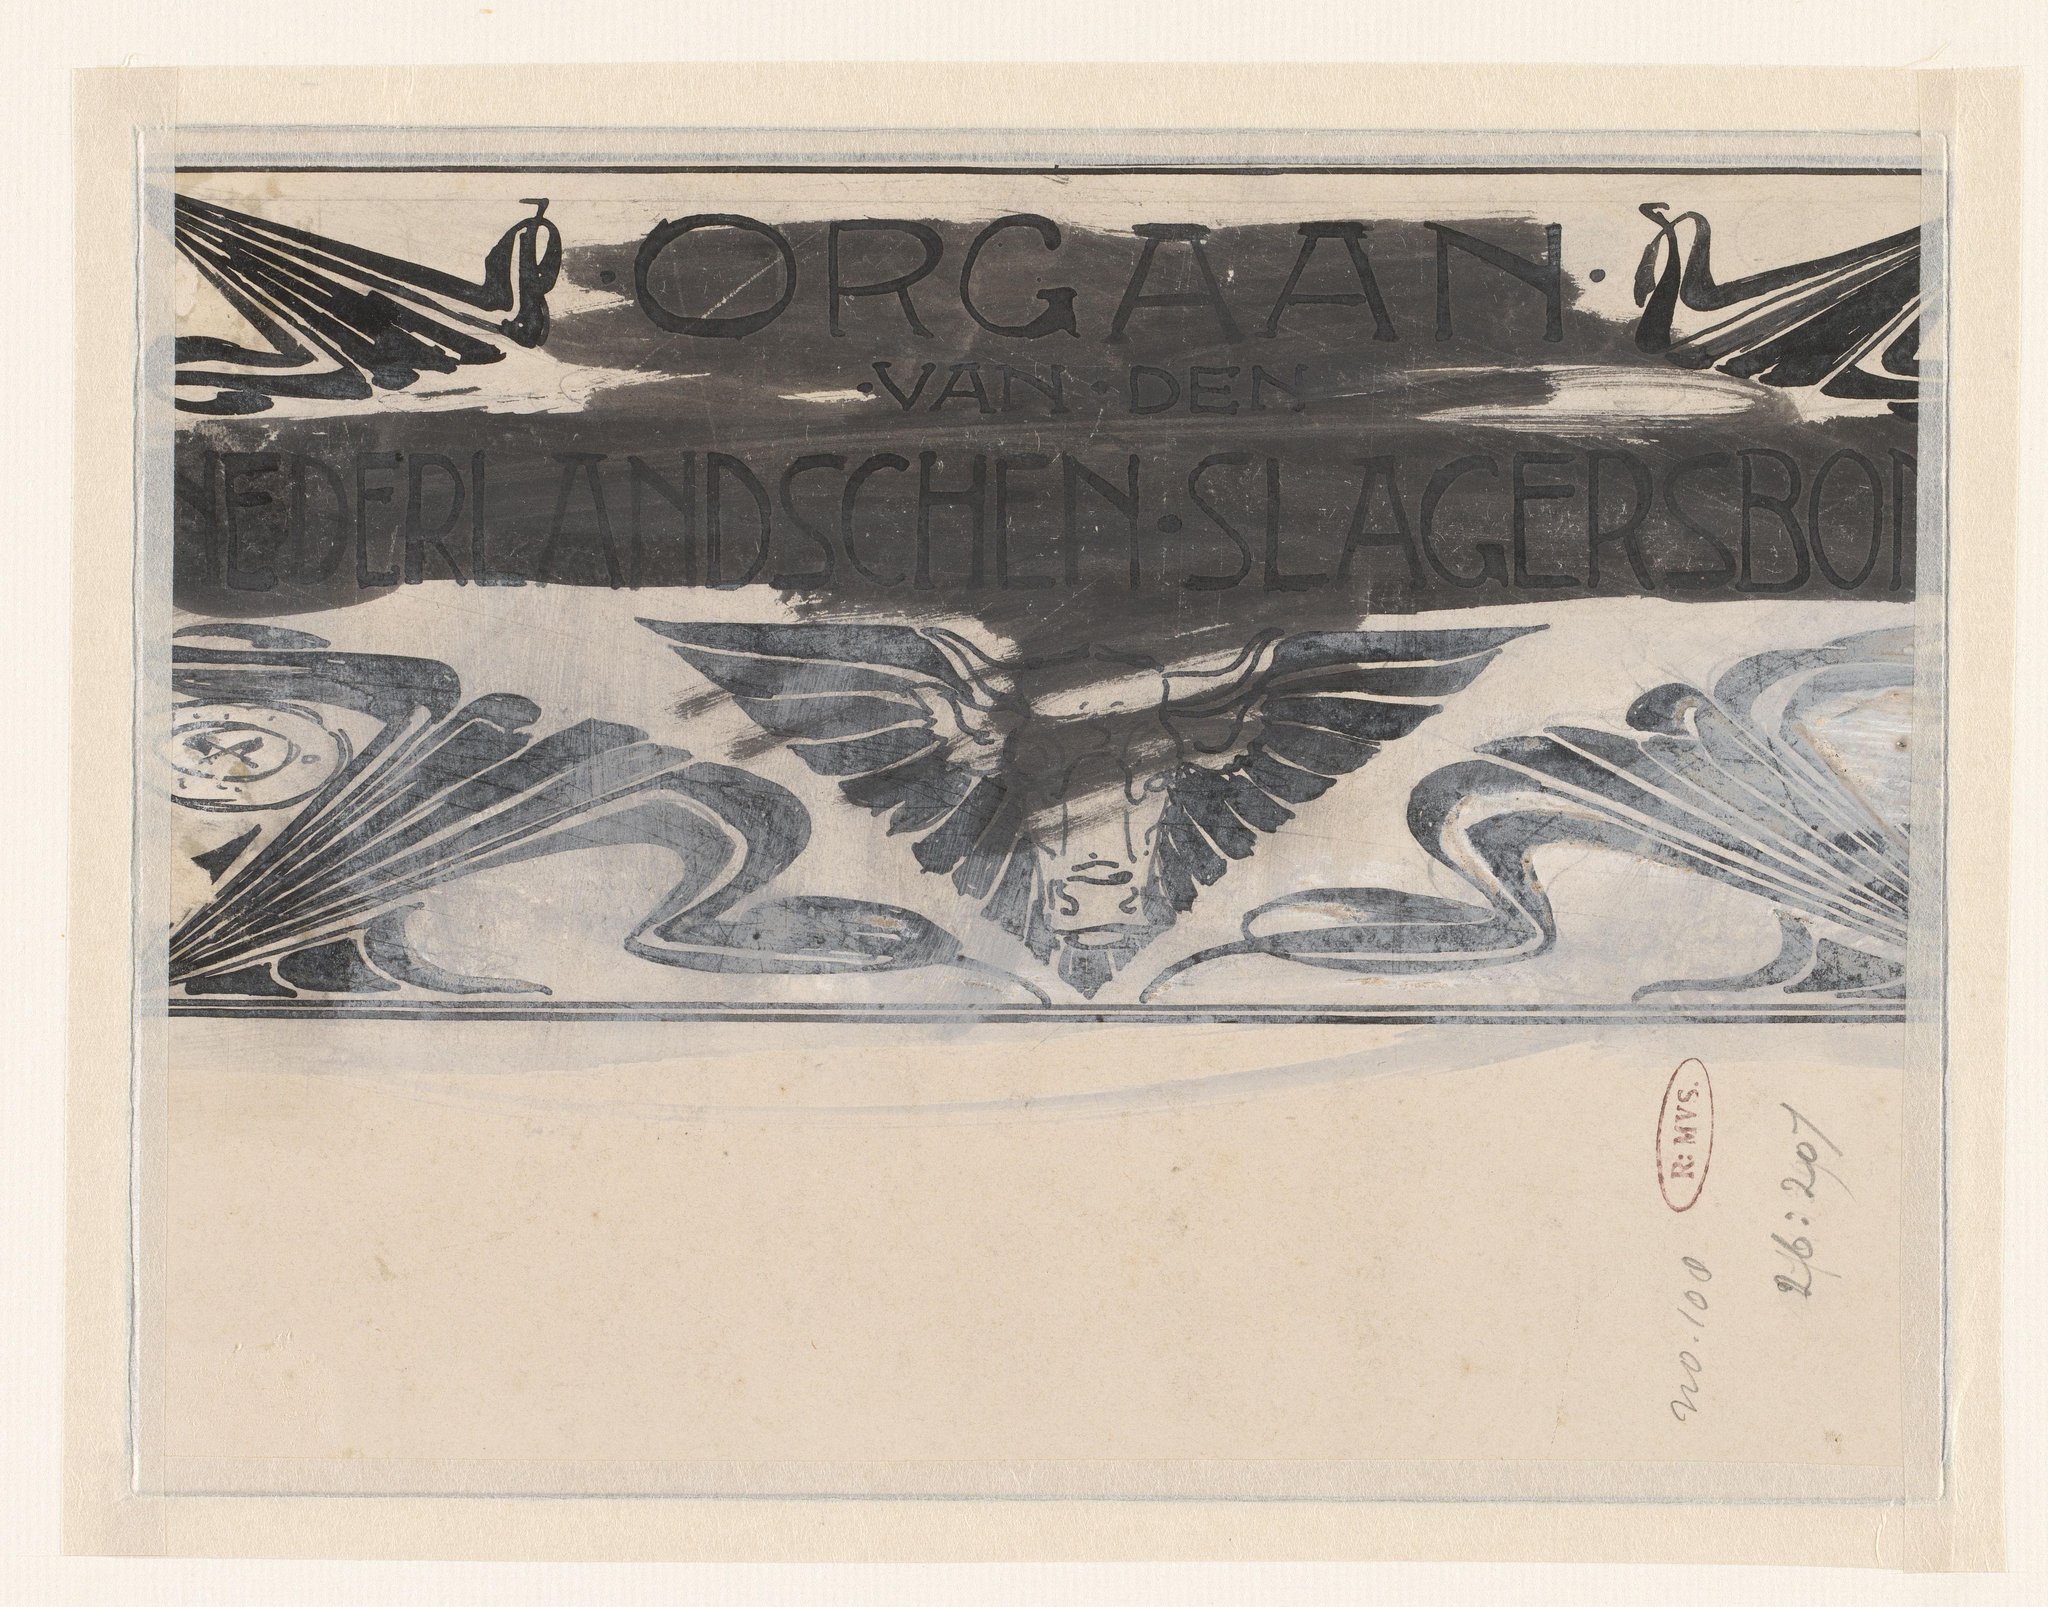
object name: design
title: Orgaan van de Nederlandschen Slagersbond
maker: willem wenckebach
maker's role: designer, draughtsman, painter, print maker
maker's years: 1860-1937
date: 1870-1926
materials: ink, paper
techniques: brush, pen